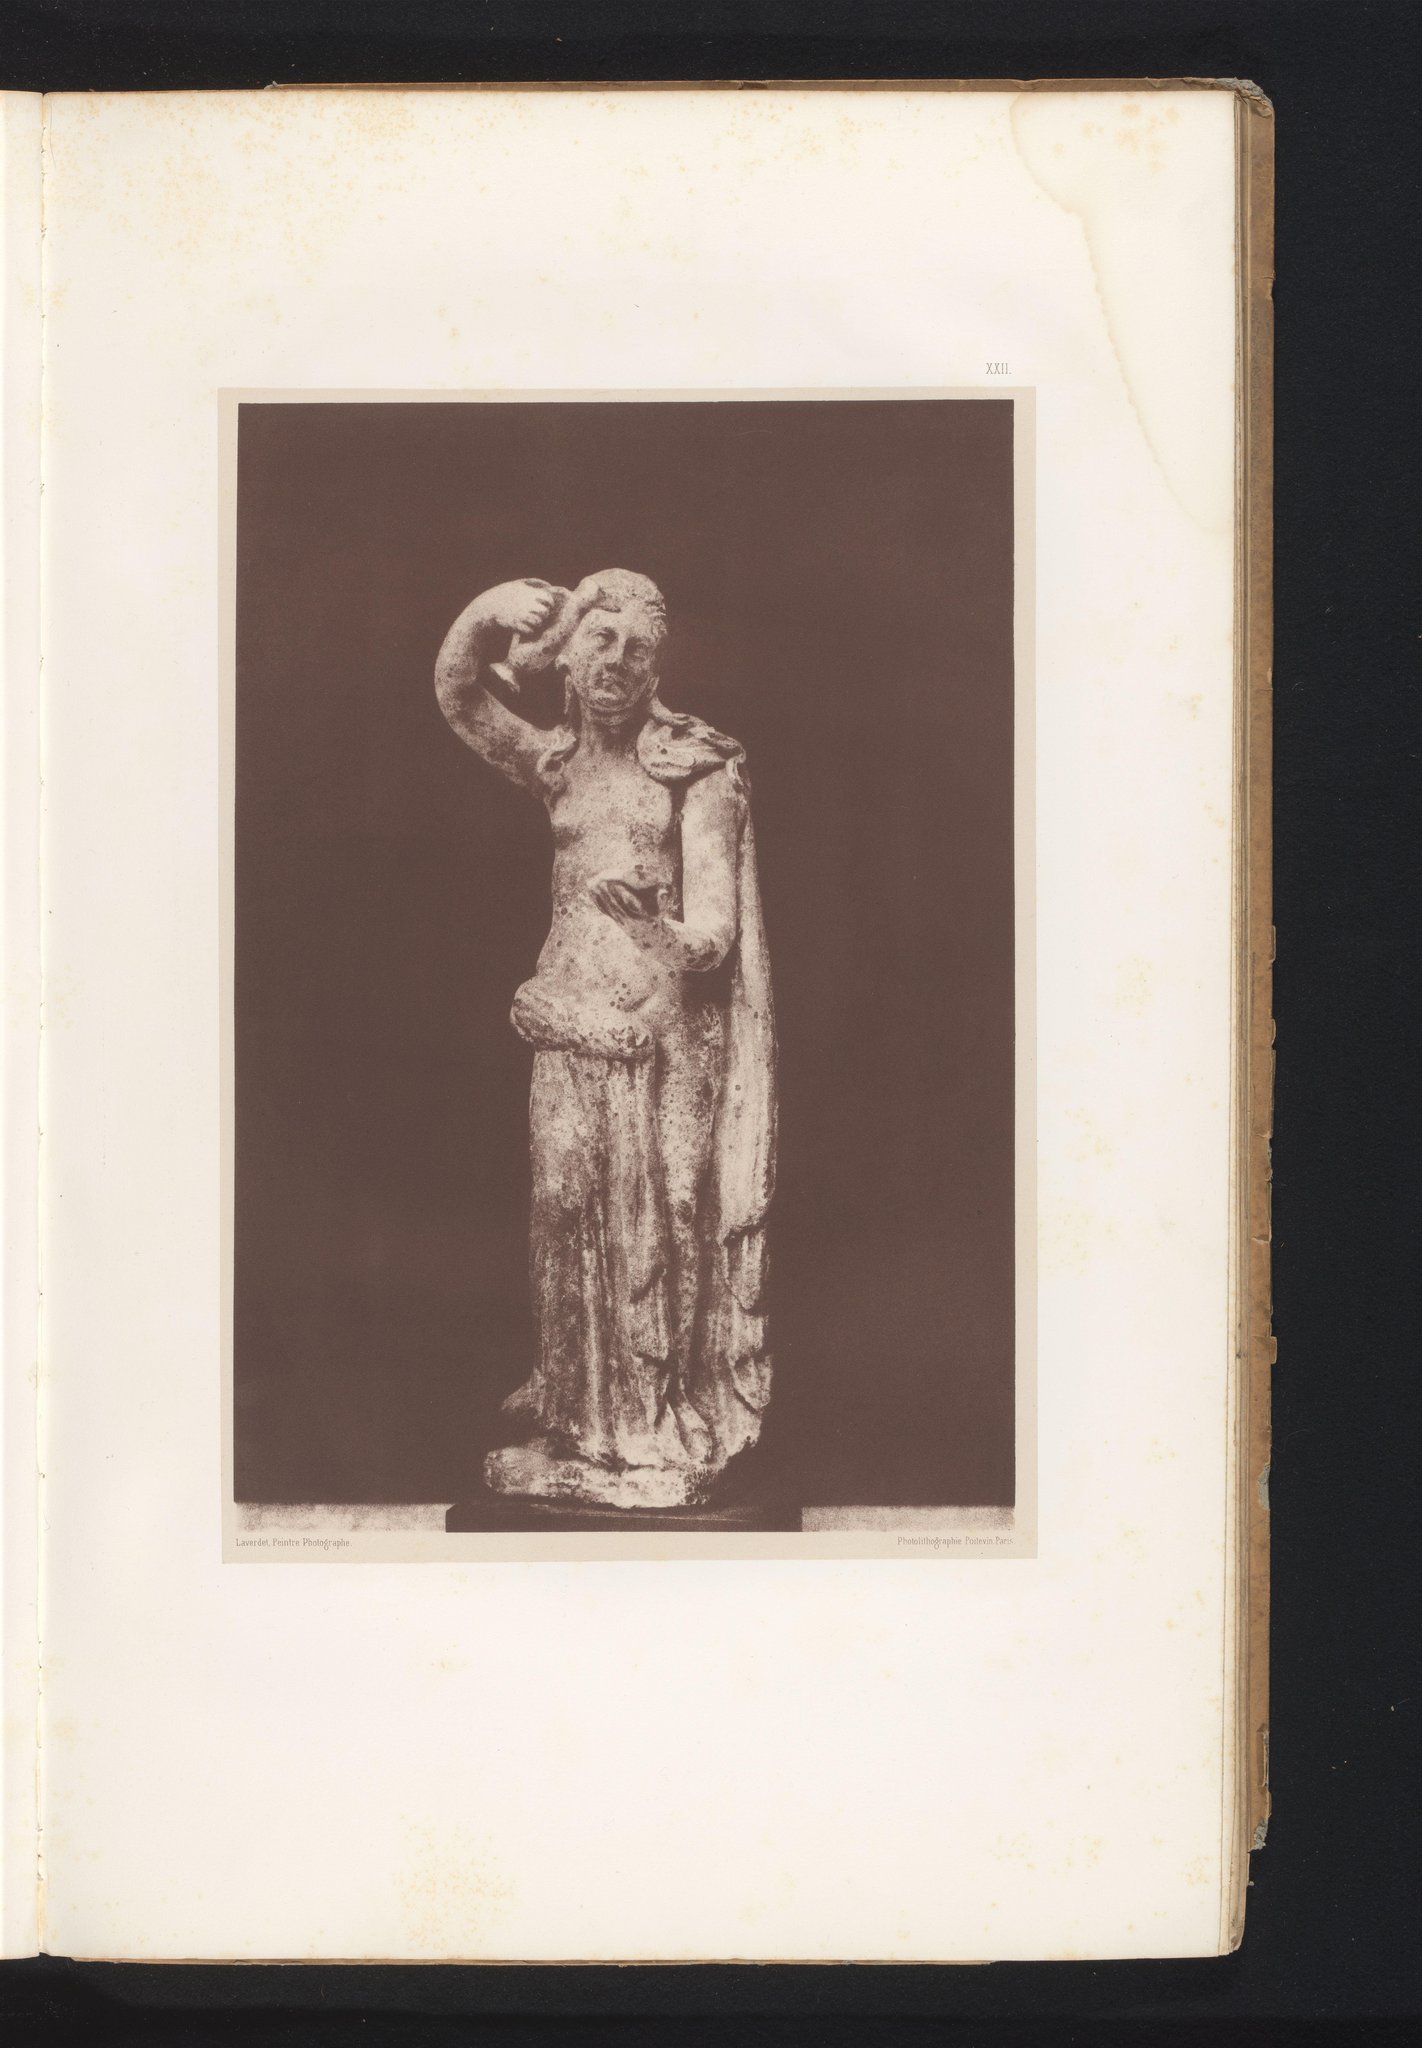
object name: photomechanical print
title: Terracotta sculptuur van Hebe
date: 1852-1857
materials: paper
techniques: photolithography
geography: paris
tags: piece of sculpture, reproduction of a piece of sculpture (+ clay, sand, etc. ~ arts), (story of) hebe (juventas)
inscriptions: number: ‘XXII.’